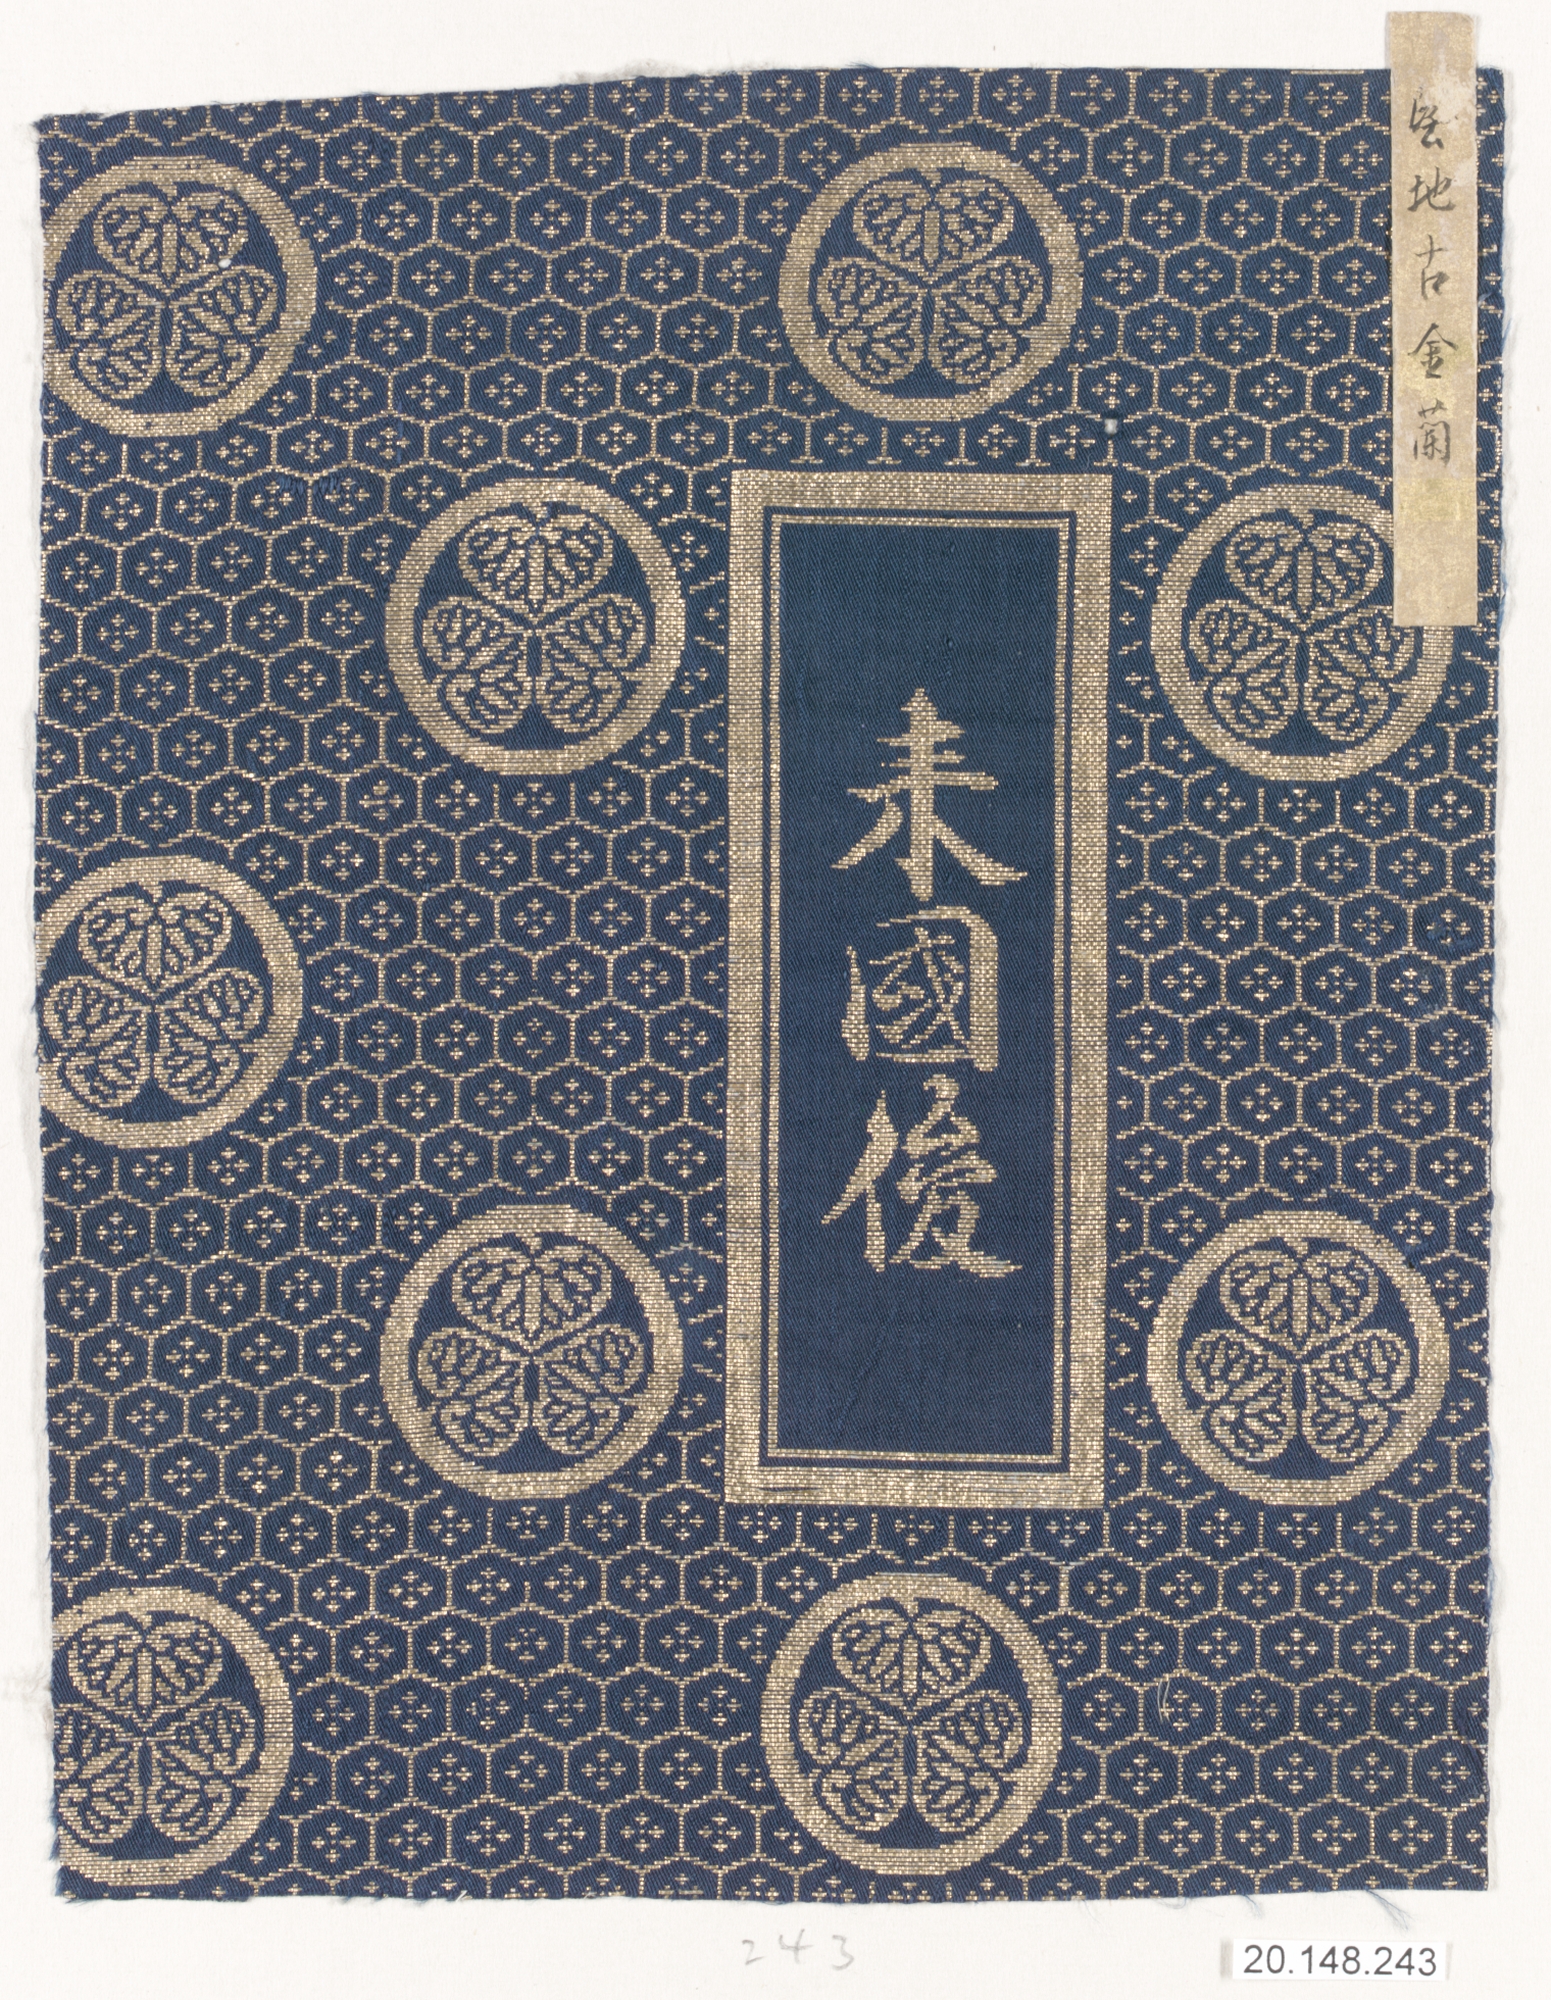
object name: piece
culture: japanese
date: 1601-1700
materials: silk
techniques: compound weave